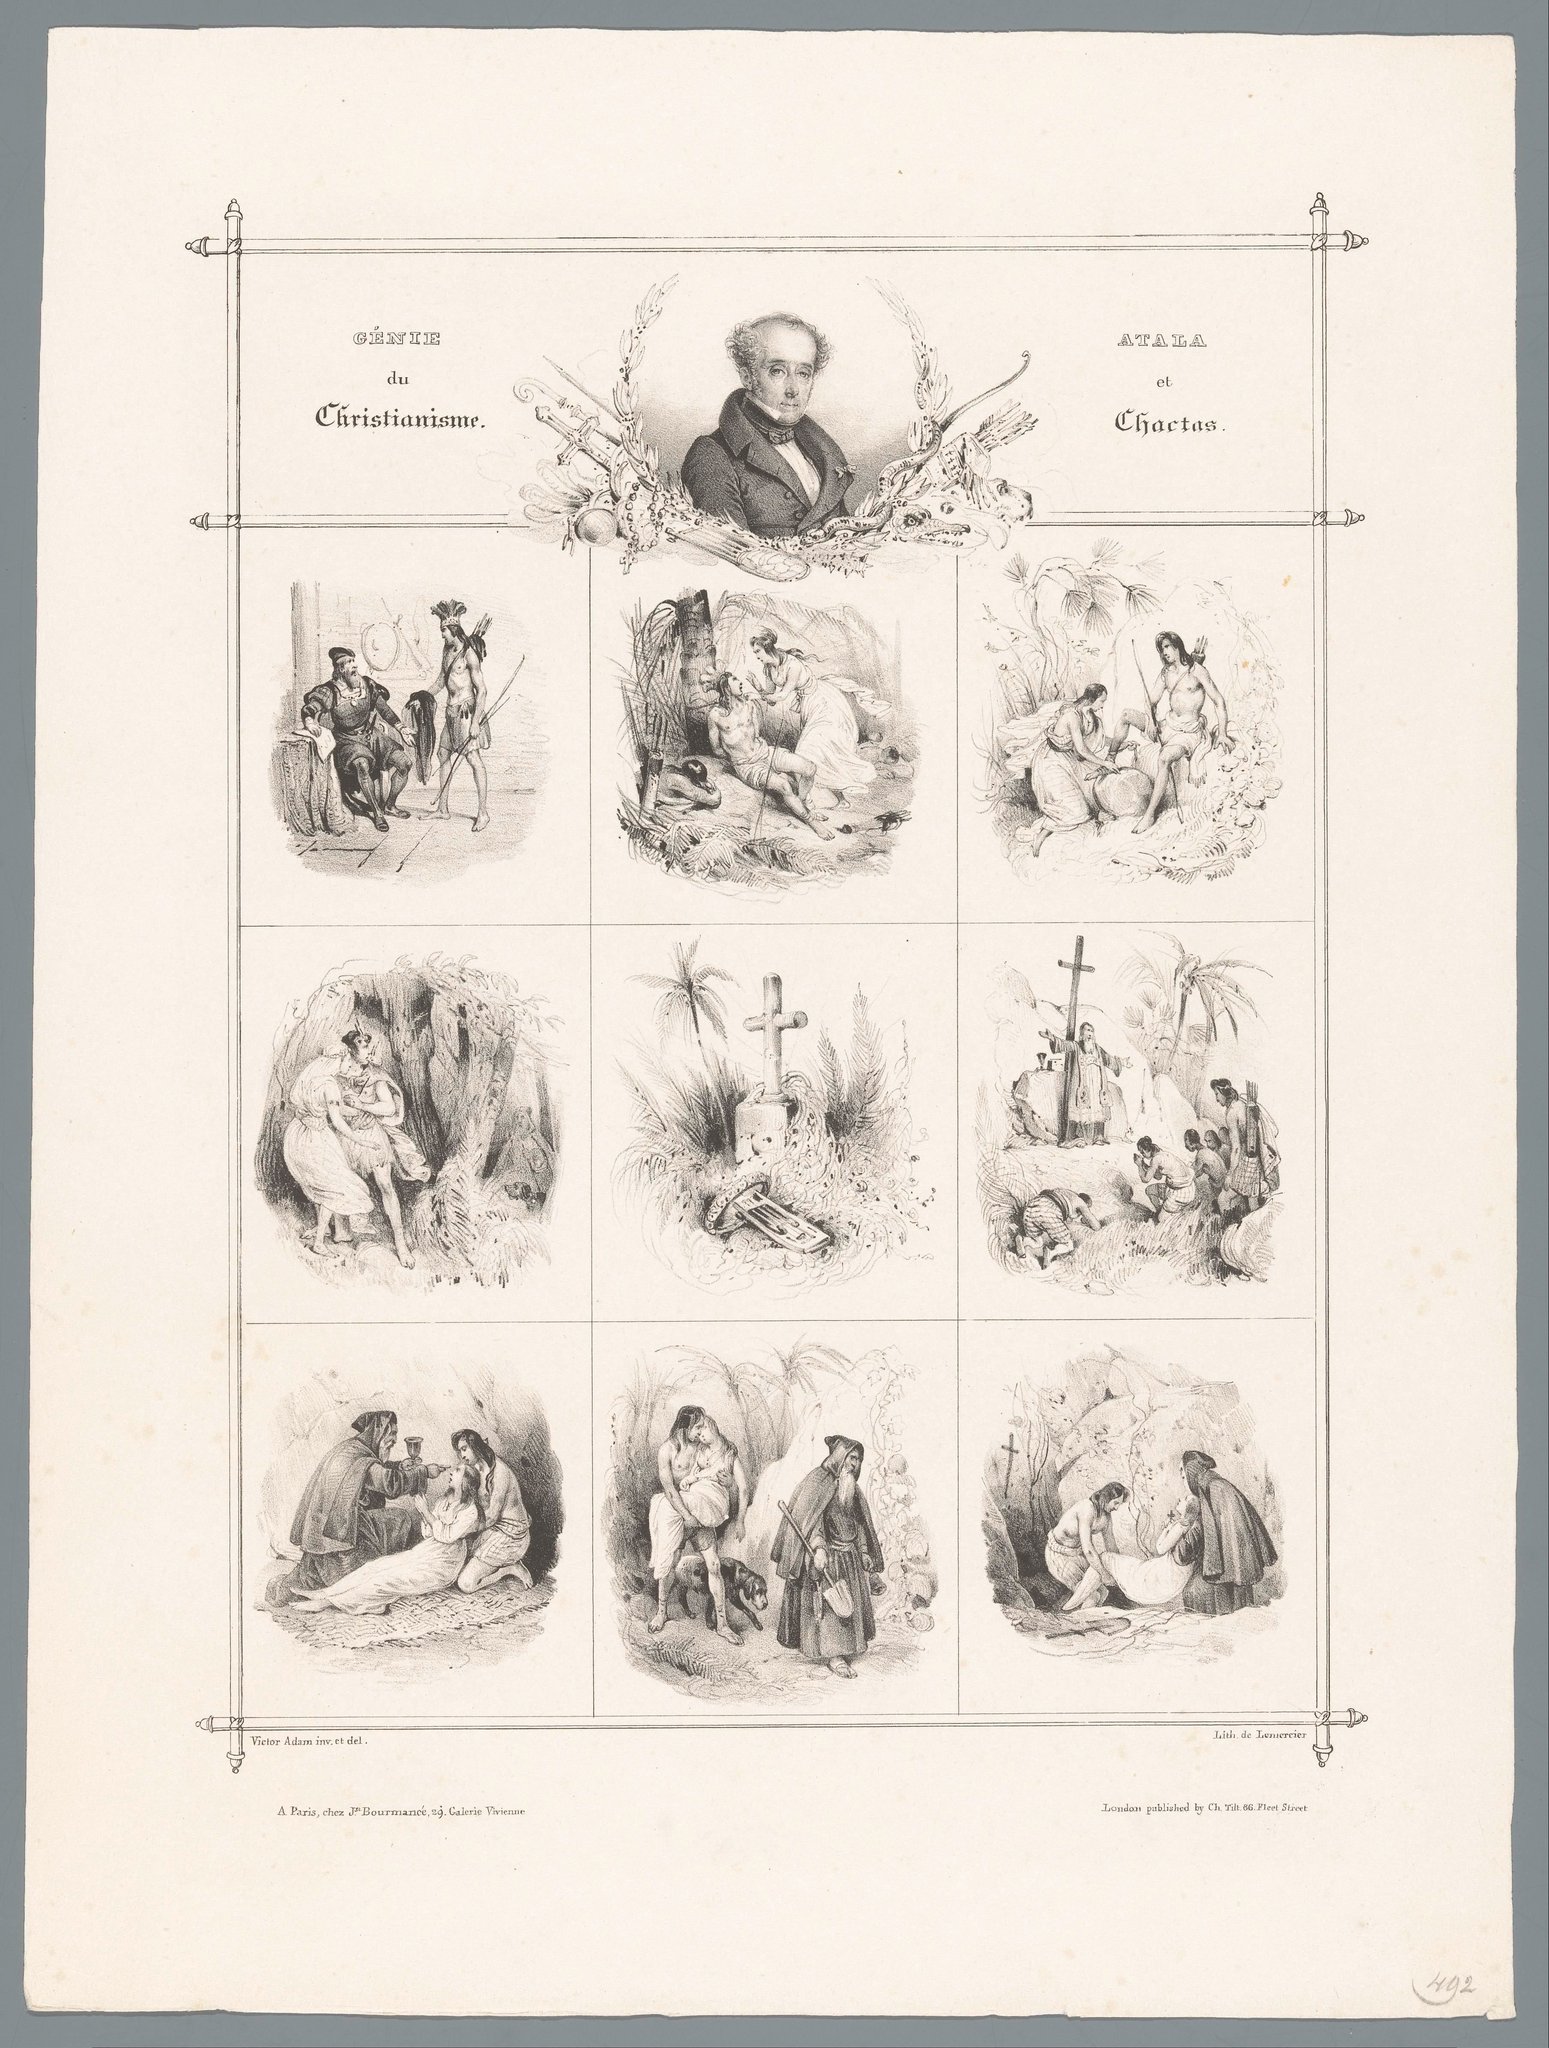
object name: print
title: Portret van François-René de Chateaubriand en negen voorstellingen uit zijn roman 'Atala'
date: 1835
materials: paper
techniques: lithograph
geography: paris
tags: paris, politician, françois-rené de chateaubriand, historical persons, portrait of a writer, (scenes from) specific works of literature (with author, title)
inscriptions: number: ‘492’, collector's mark: Lugt 2228